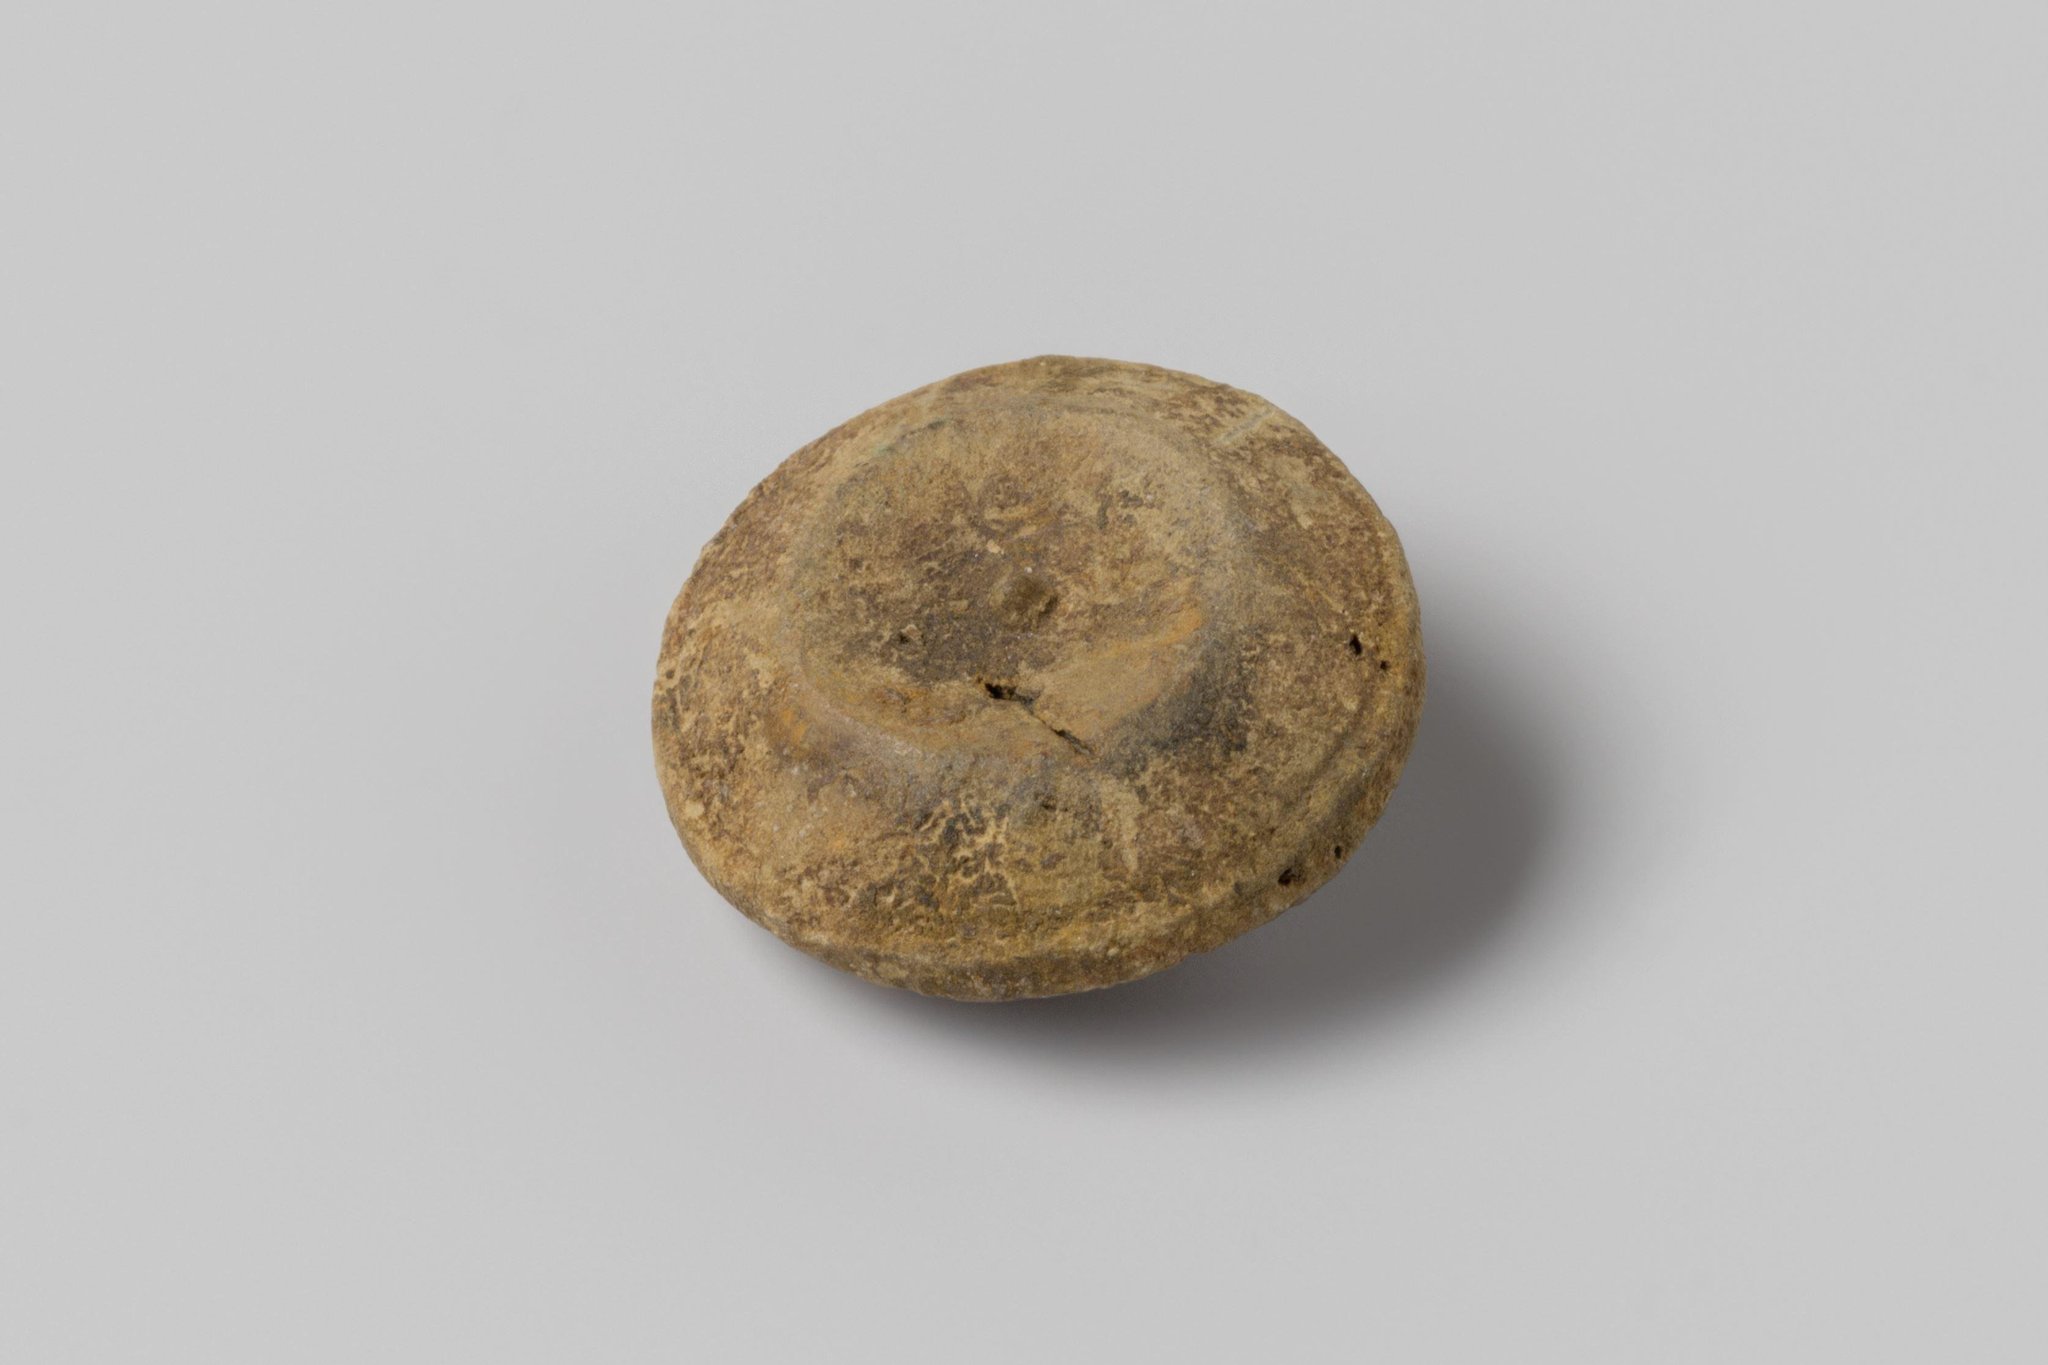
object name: button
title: Knoop uit het wrak van de Oost-Indiëvaarder Hollandia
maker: Anonymous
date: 1700-1743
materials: bone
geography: netherlands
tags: verenigde oostindische compagnie, hollandia (schip), annet